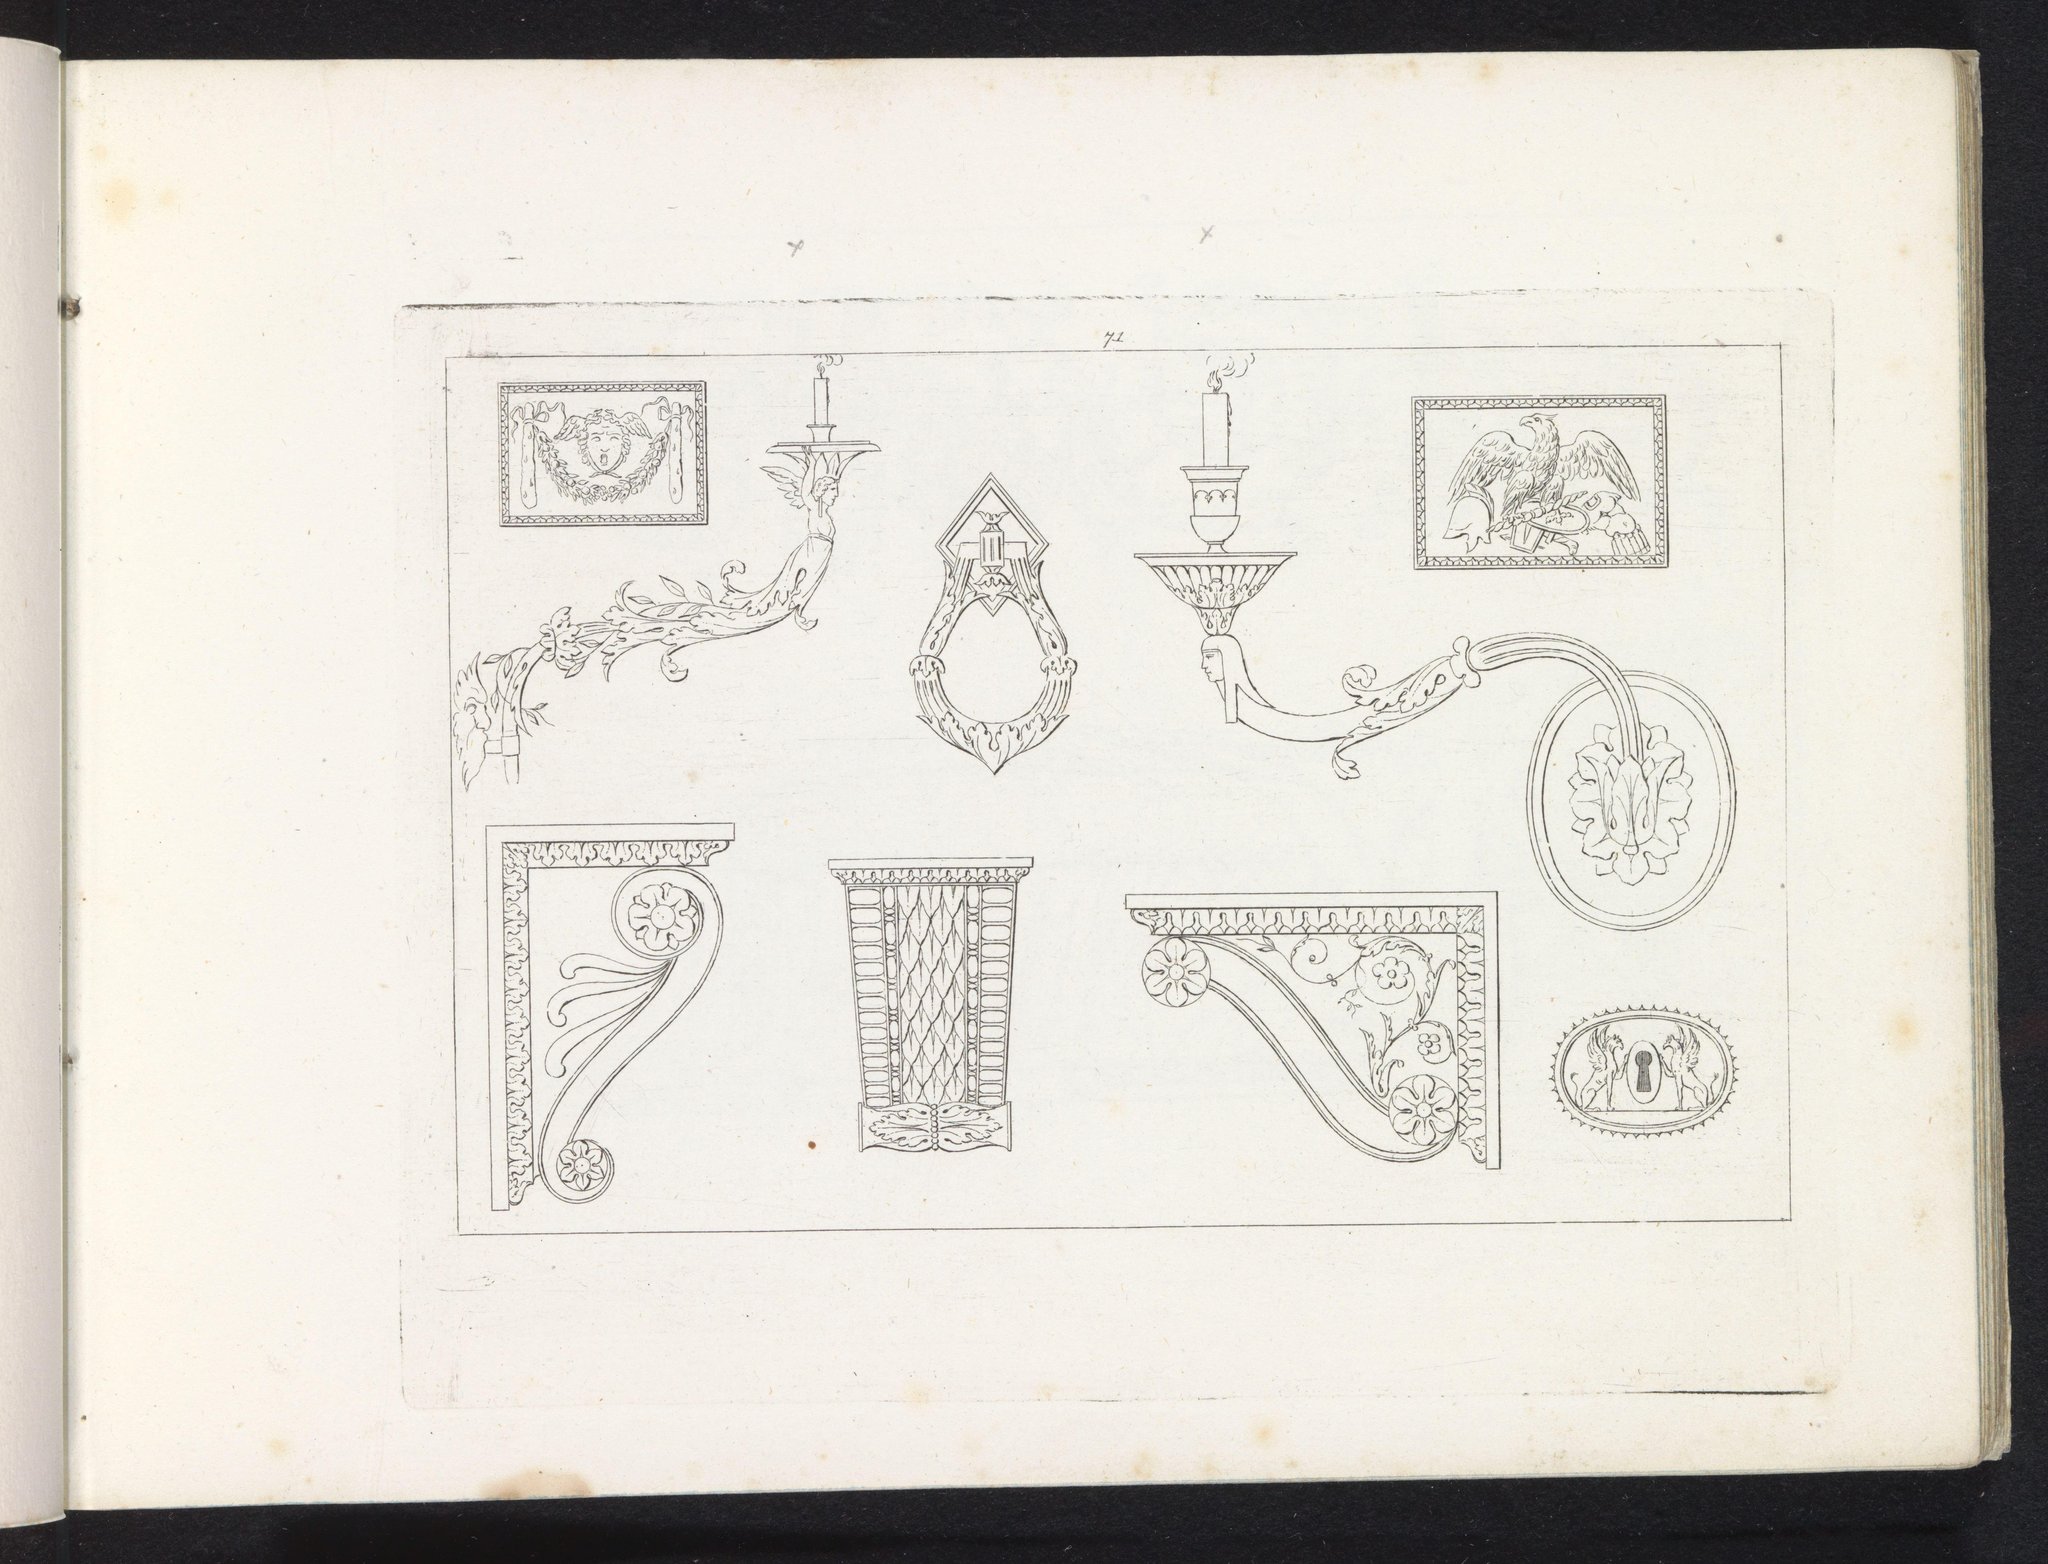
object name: album leaf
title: Wandkandelaars, consoles en een slot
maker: pietro ruga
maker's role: print maker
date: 1817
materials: paper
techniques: etching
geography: italy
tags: lock ~ door, ornaments ~ art, chandelier, candelabrum, other architectural details (console)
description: Prent maakt deel uit van een reeks van 100 prenten (+ titelprent) met ontwerpen voor religieuze en profane voorwerpen.